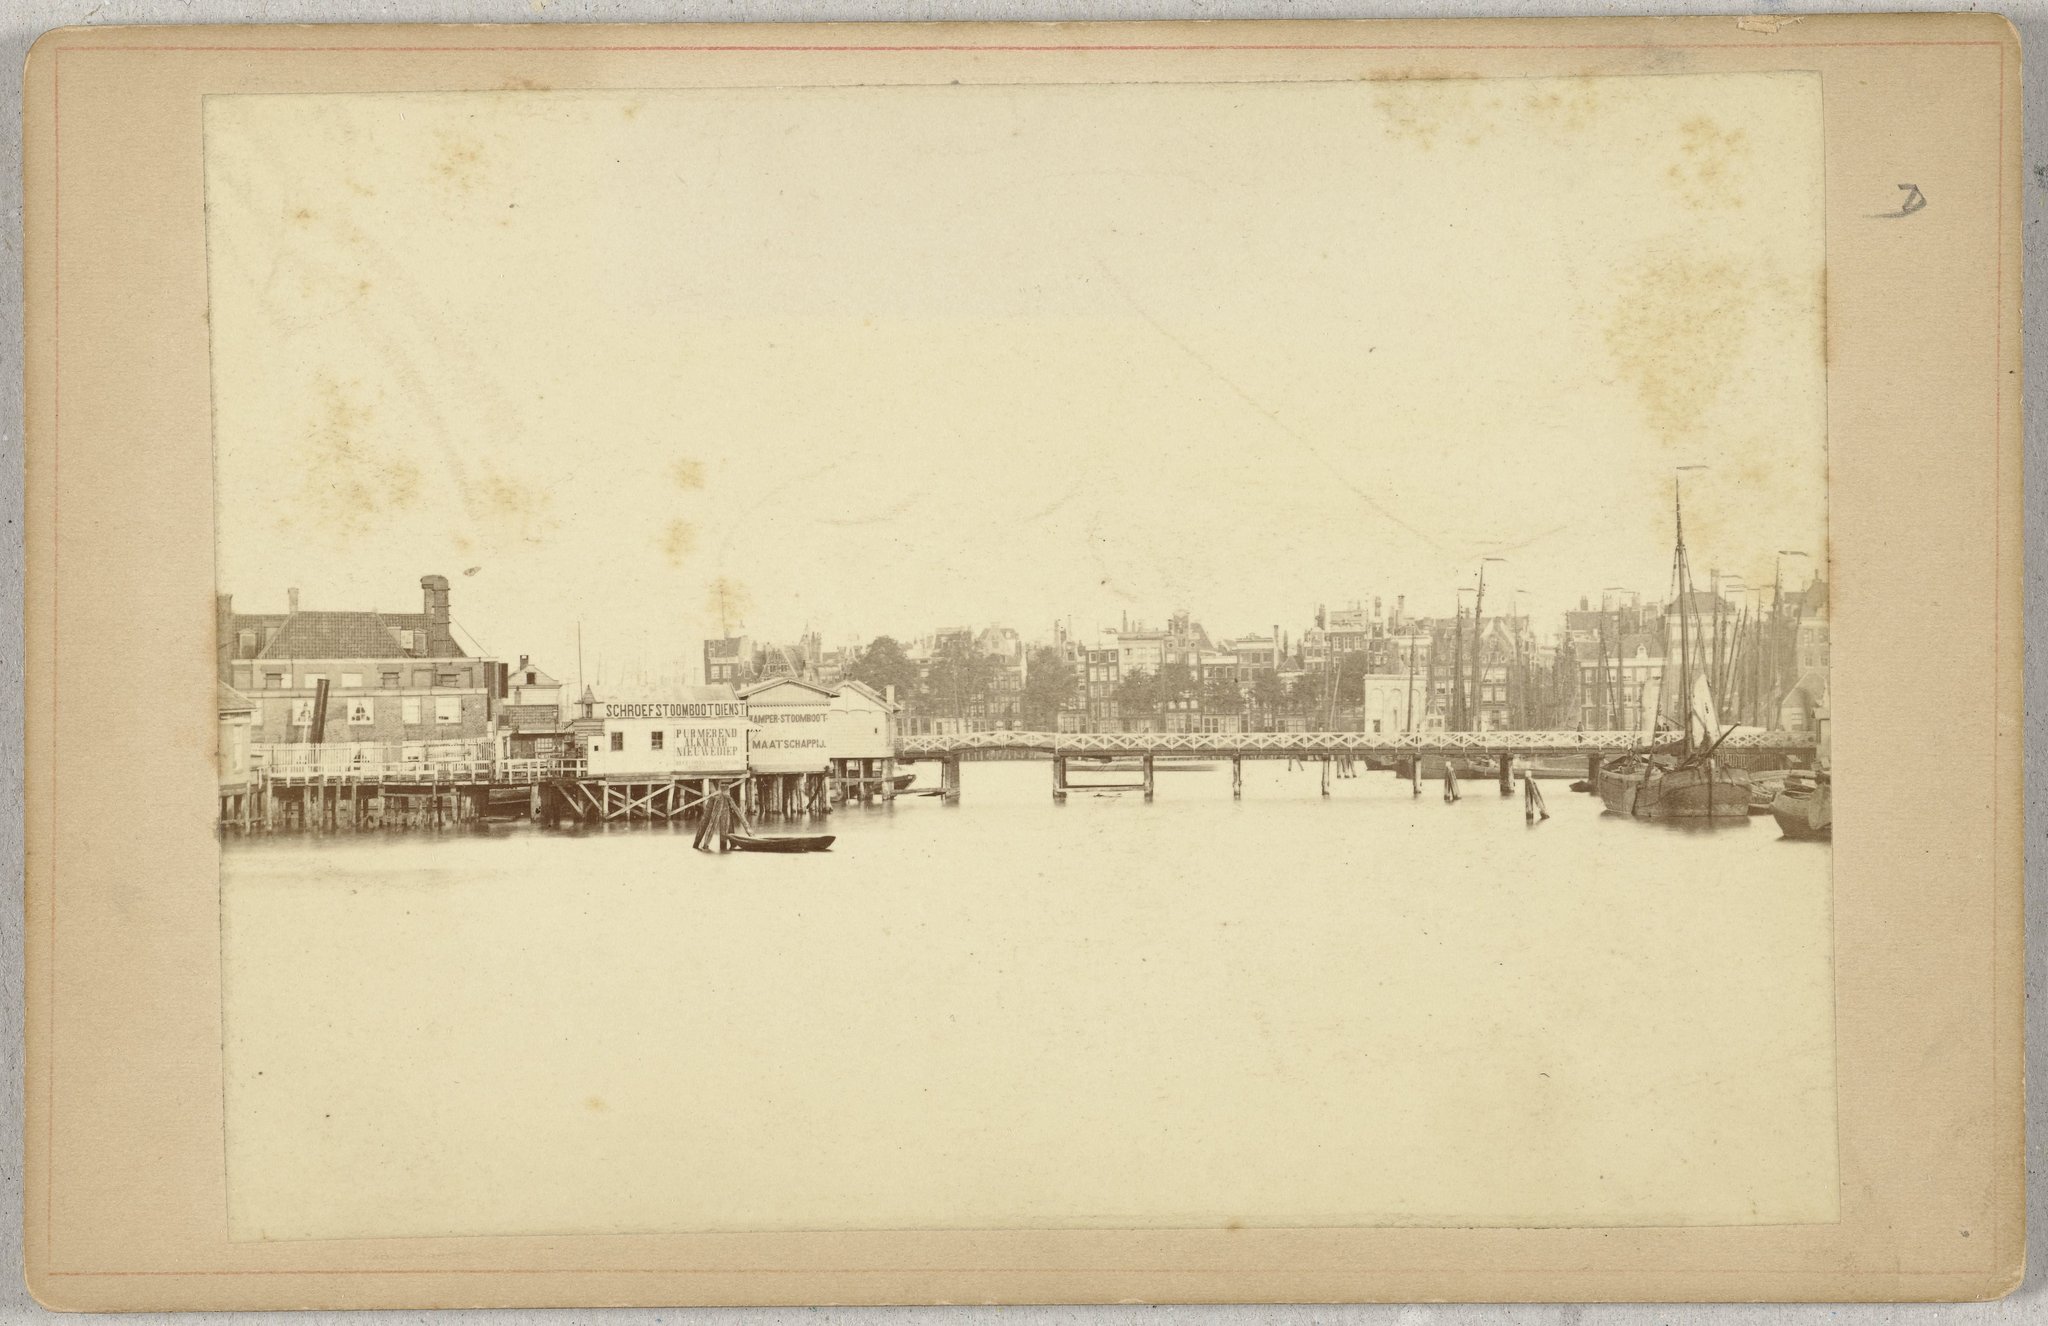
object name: photograph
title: Stadsherberg met aanlegsteiger op de plaats van het tegenwoordige centraal station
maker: paul henri jean reynet de la rue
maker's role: boekhandelaar, drukkerij, fotograaf, lijstenmaker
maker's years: 1839-1927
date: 1860-1880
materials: cardboard, paper, photographic support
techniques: albumen print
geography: amsterdam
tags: river, inn, coffee-house, public house, etc., canals, waters (in city), amsterdam